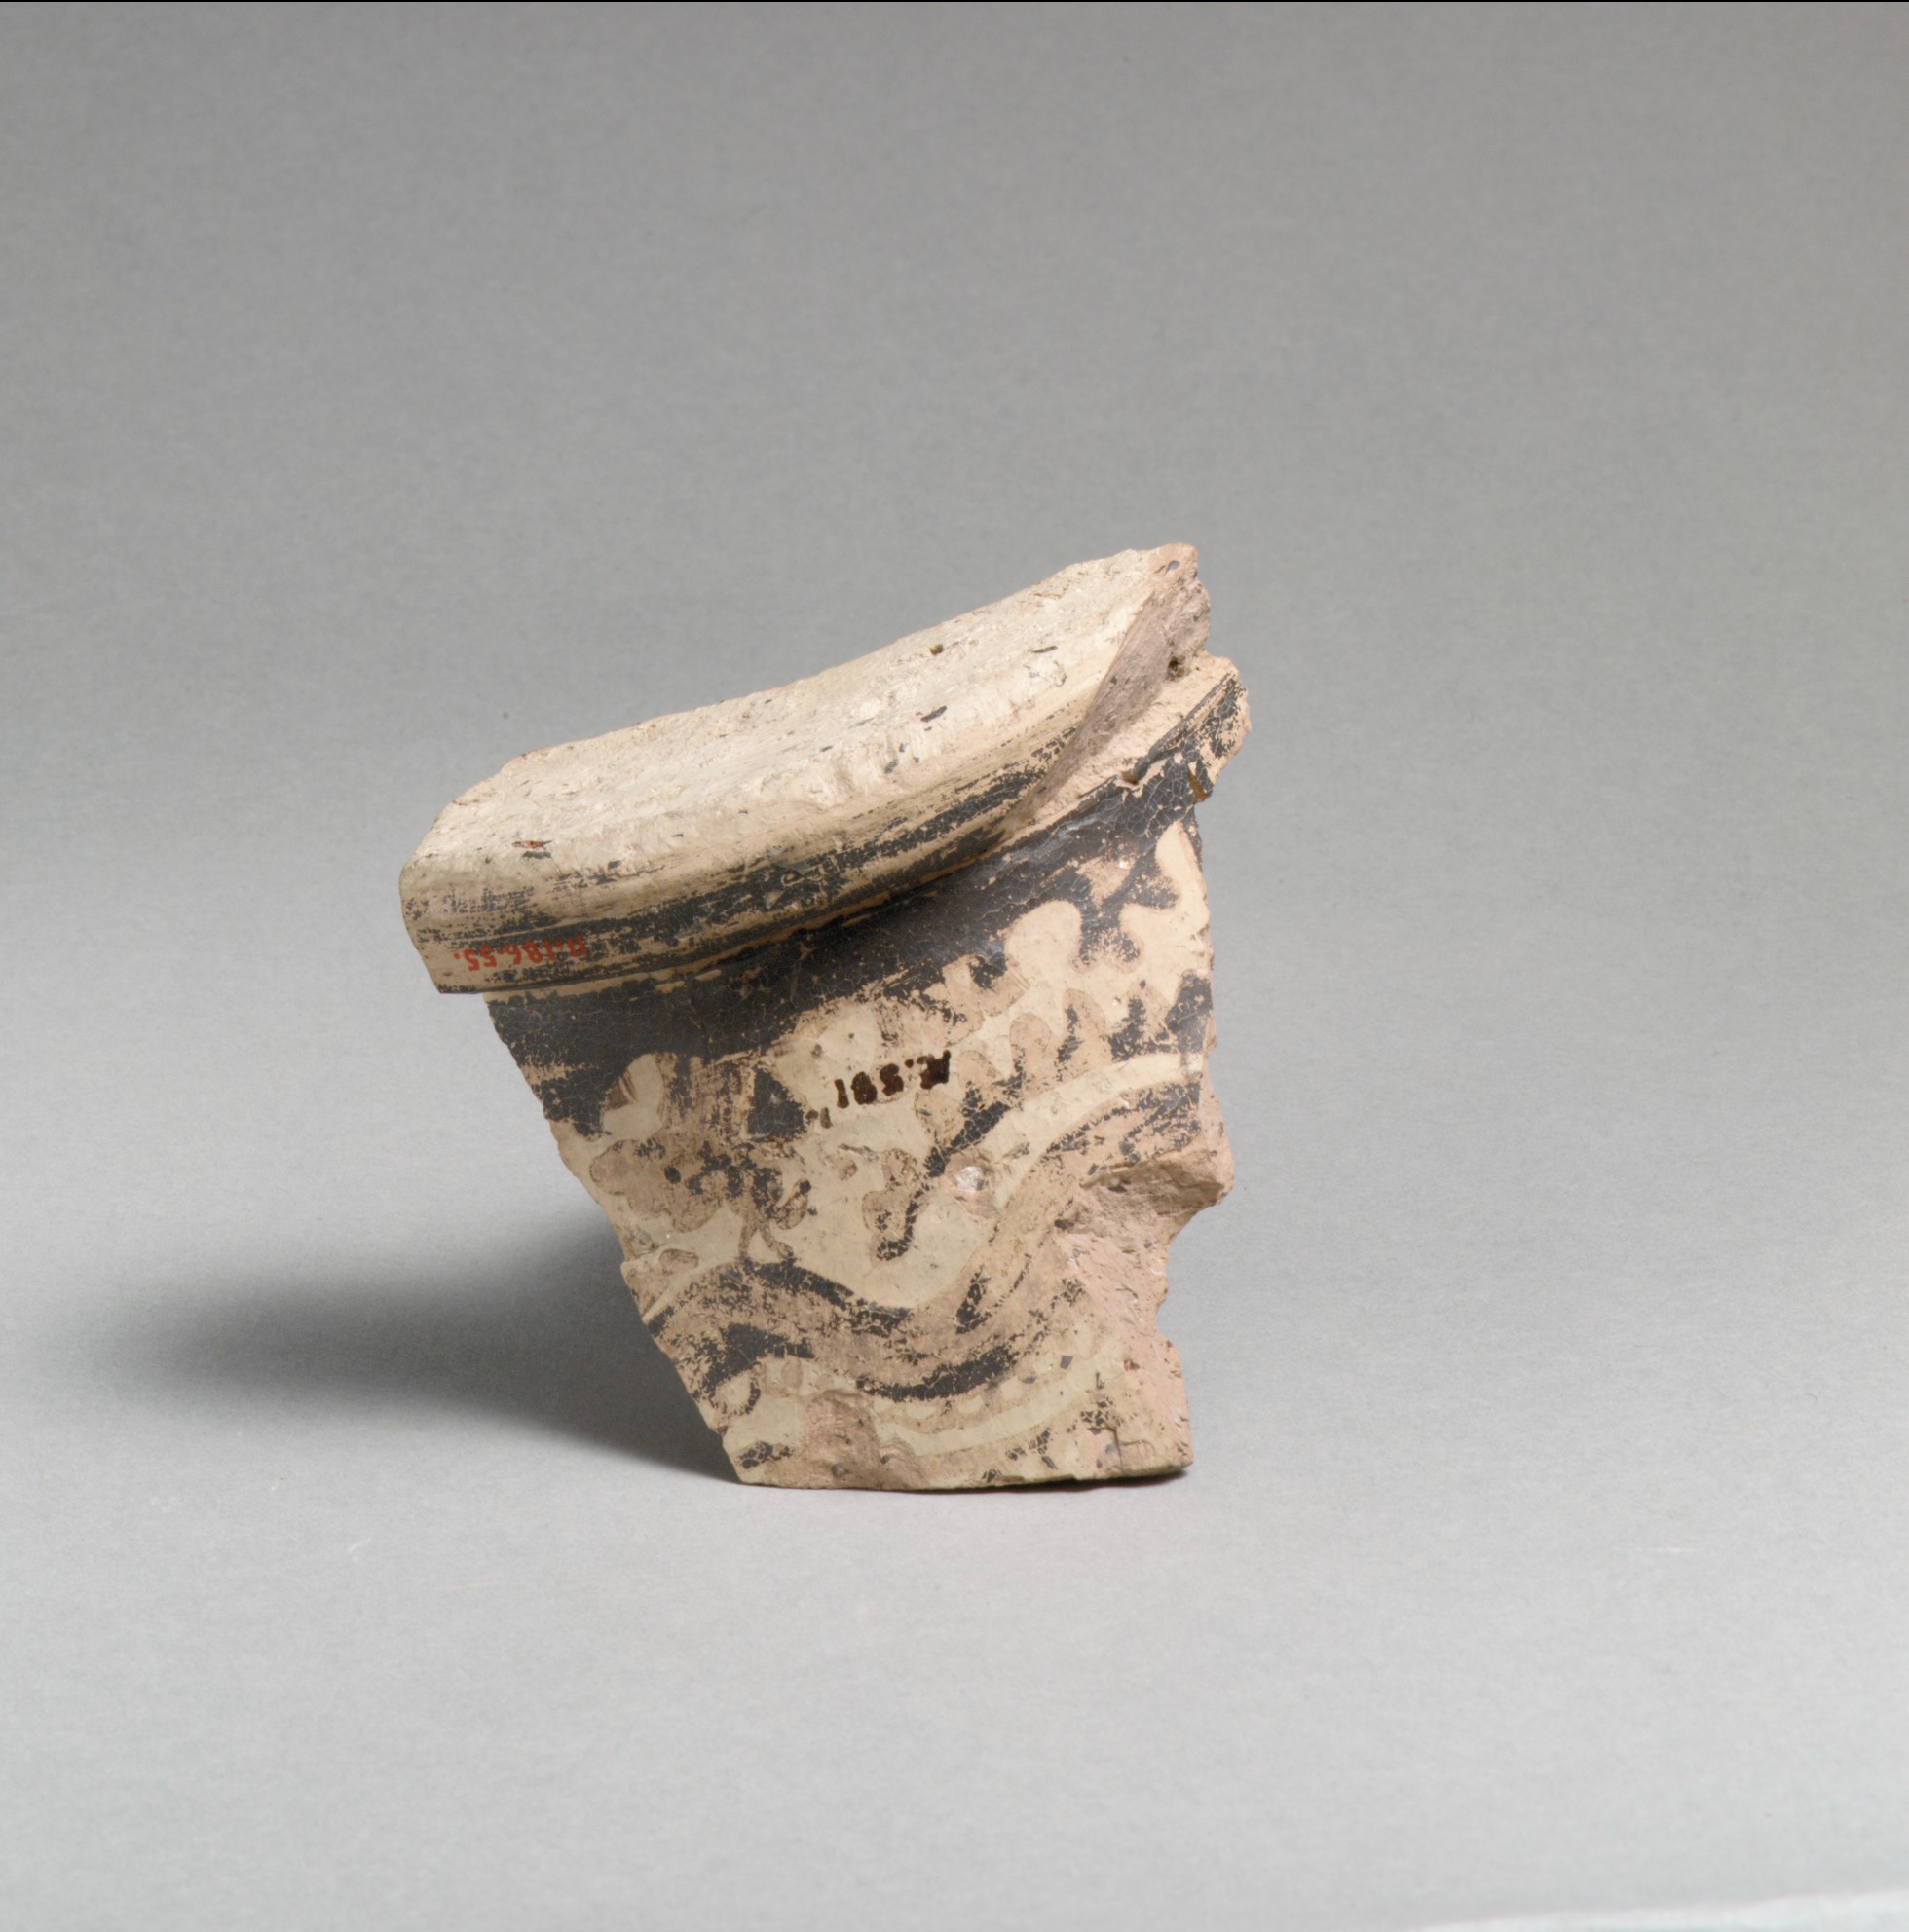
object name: vase fragment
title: Terracotta base of cup with marine design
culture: minoan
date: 1525-1450 BCE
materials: terracotta